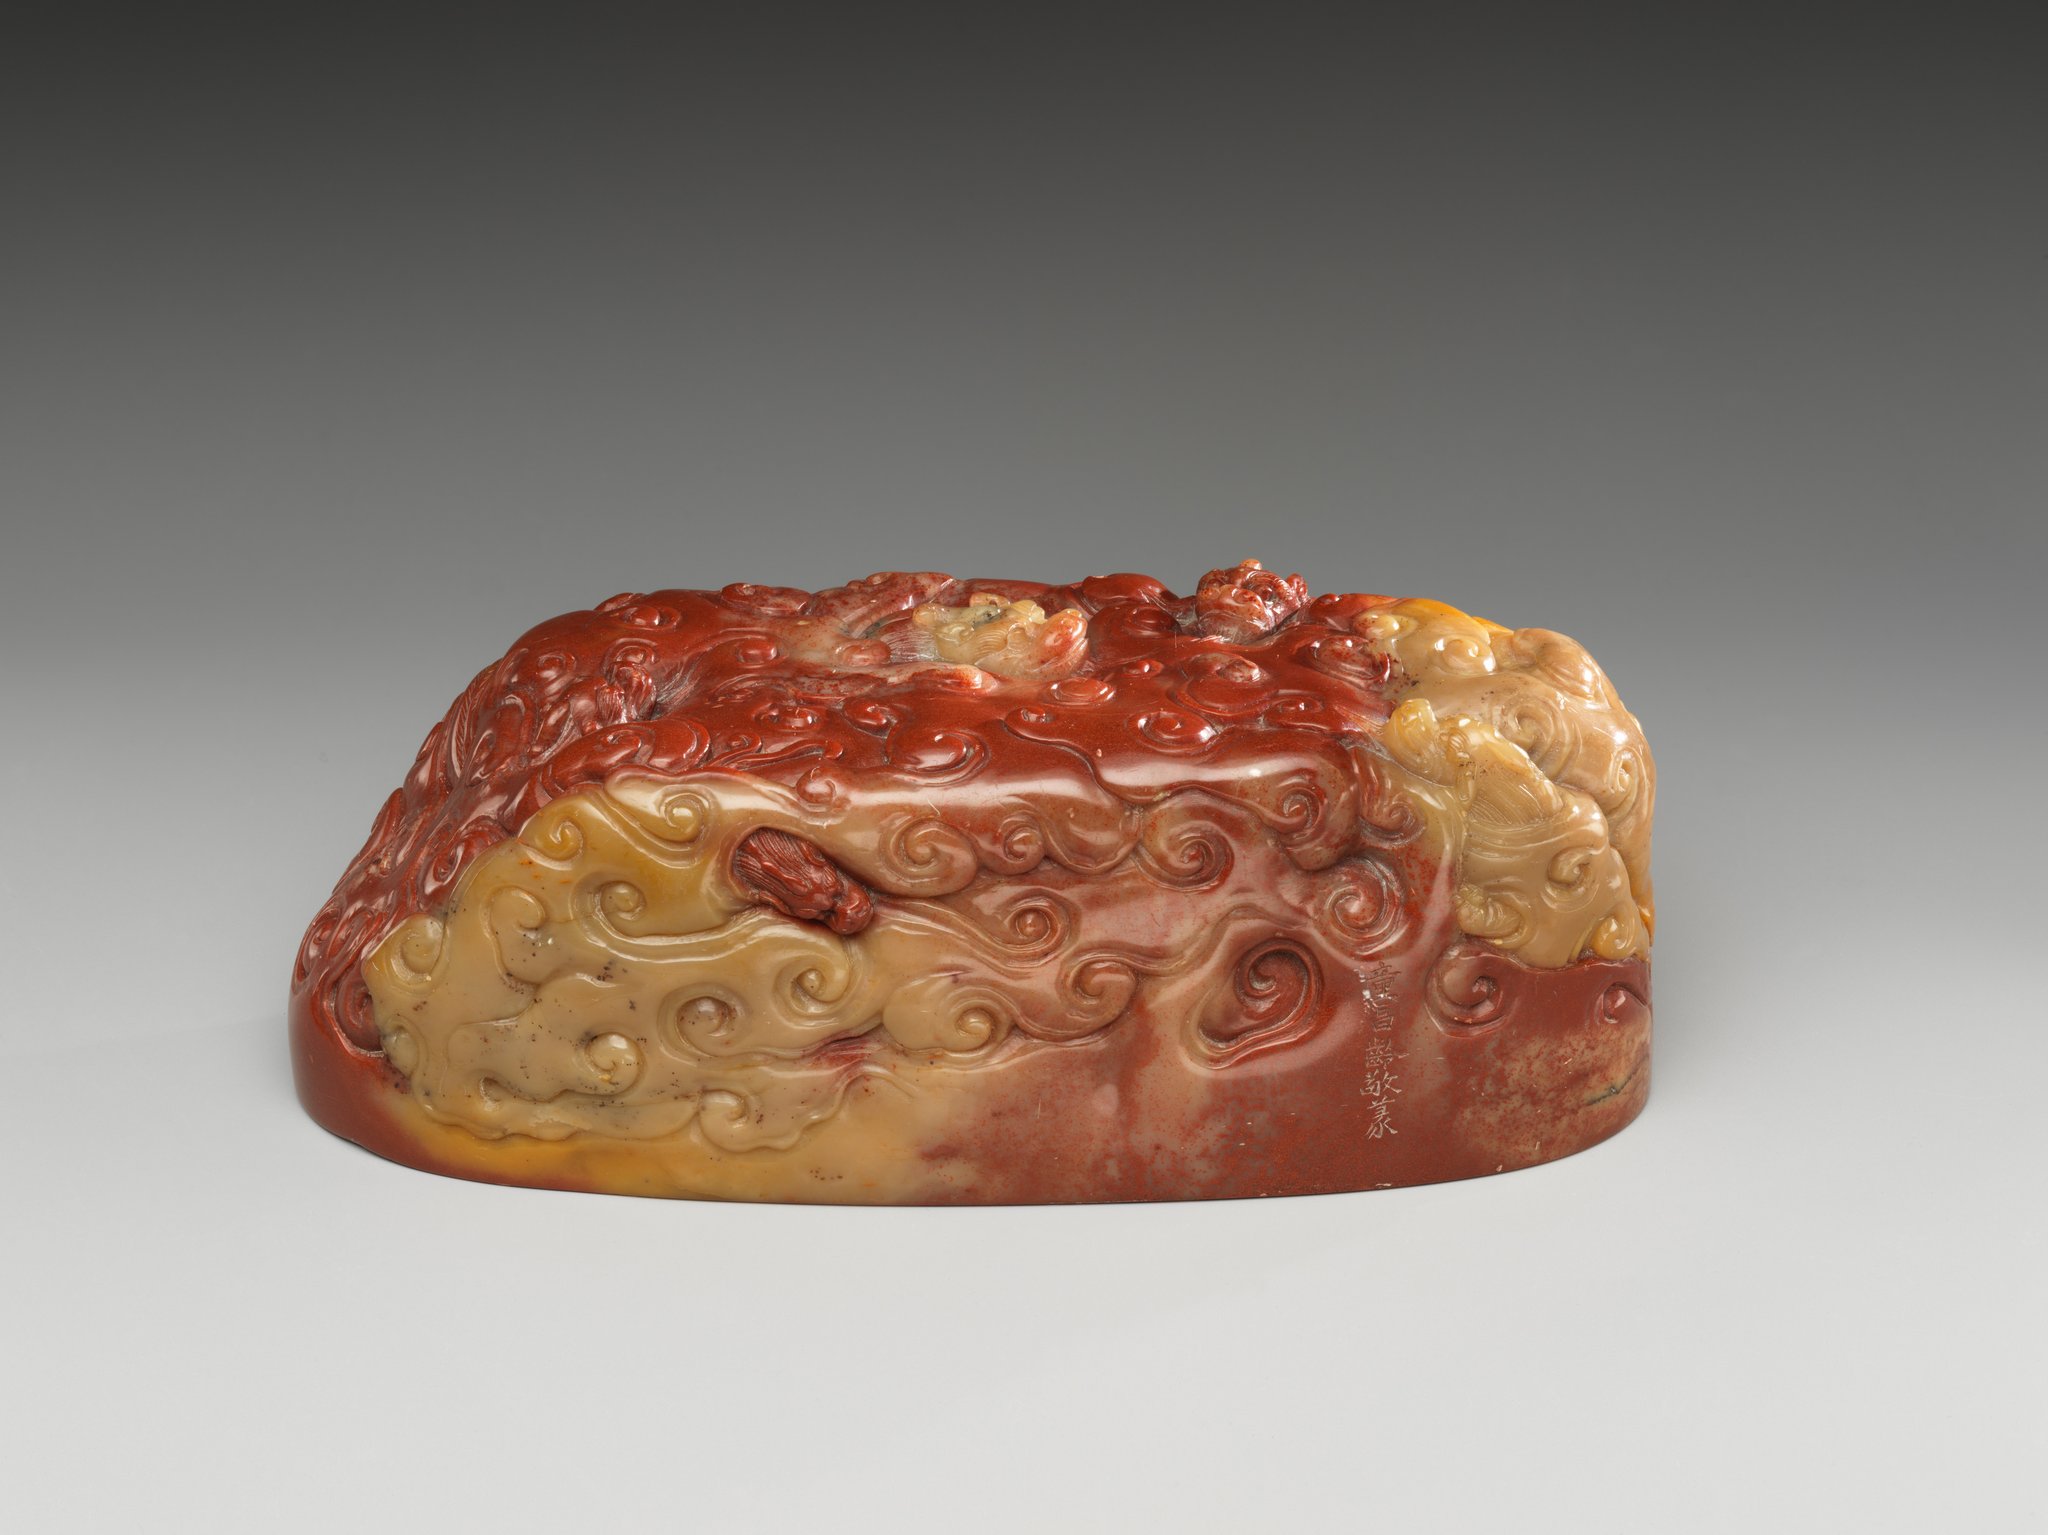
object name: paperweight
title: Paper weight with chi dragons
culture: chinese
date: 1701-1800